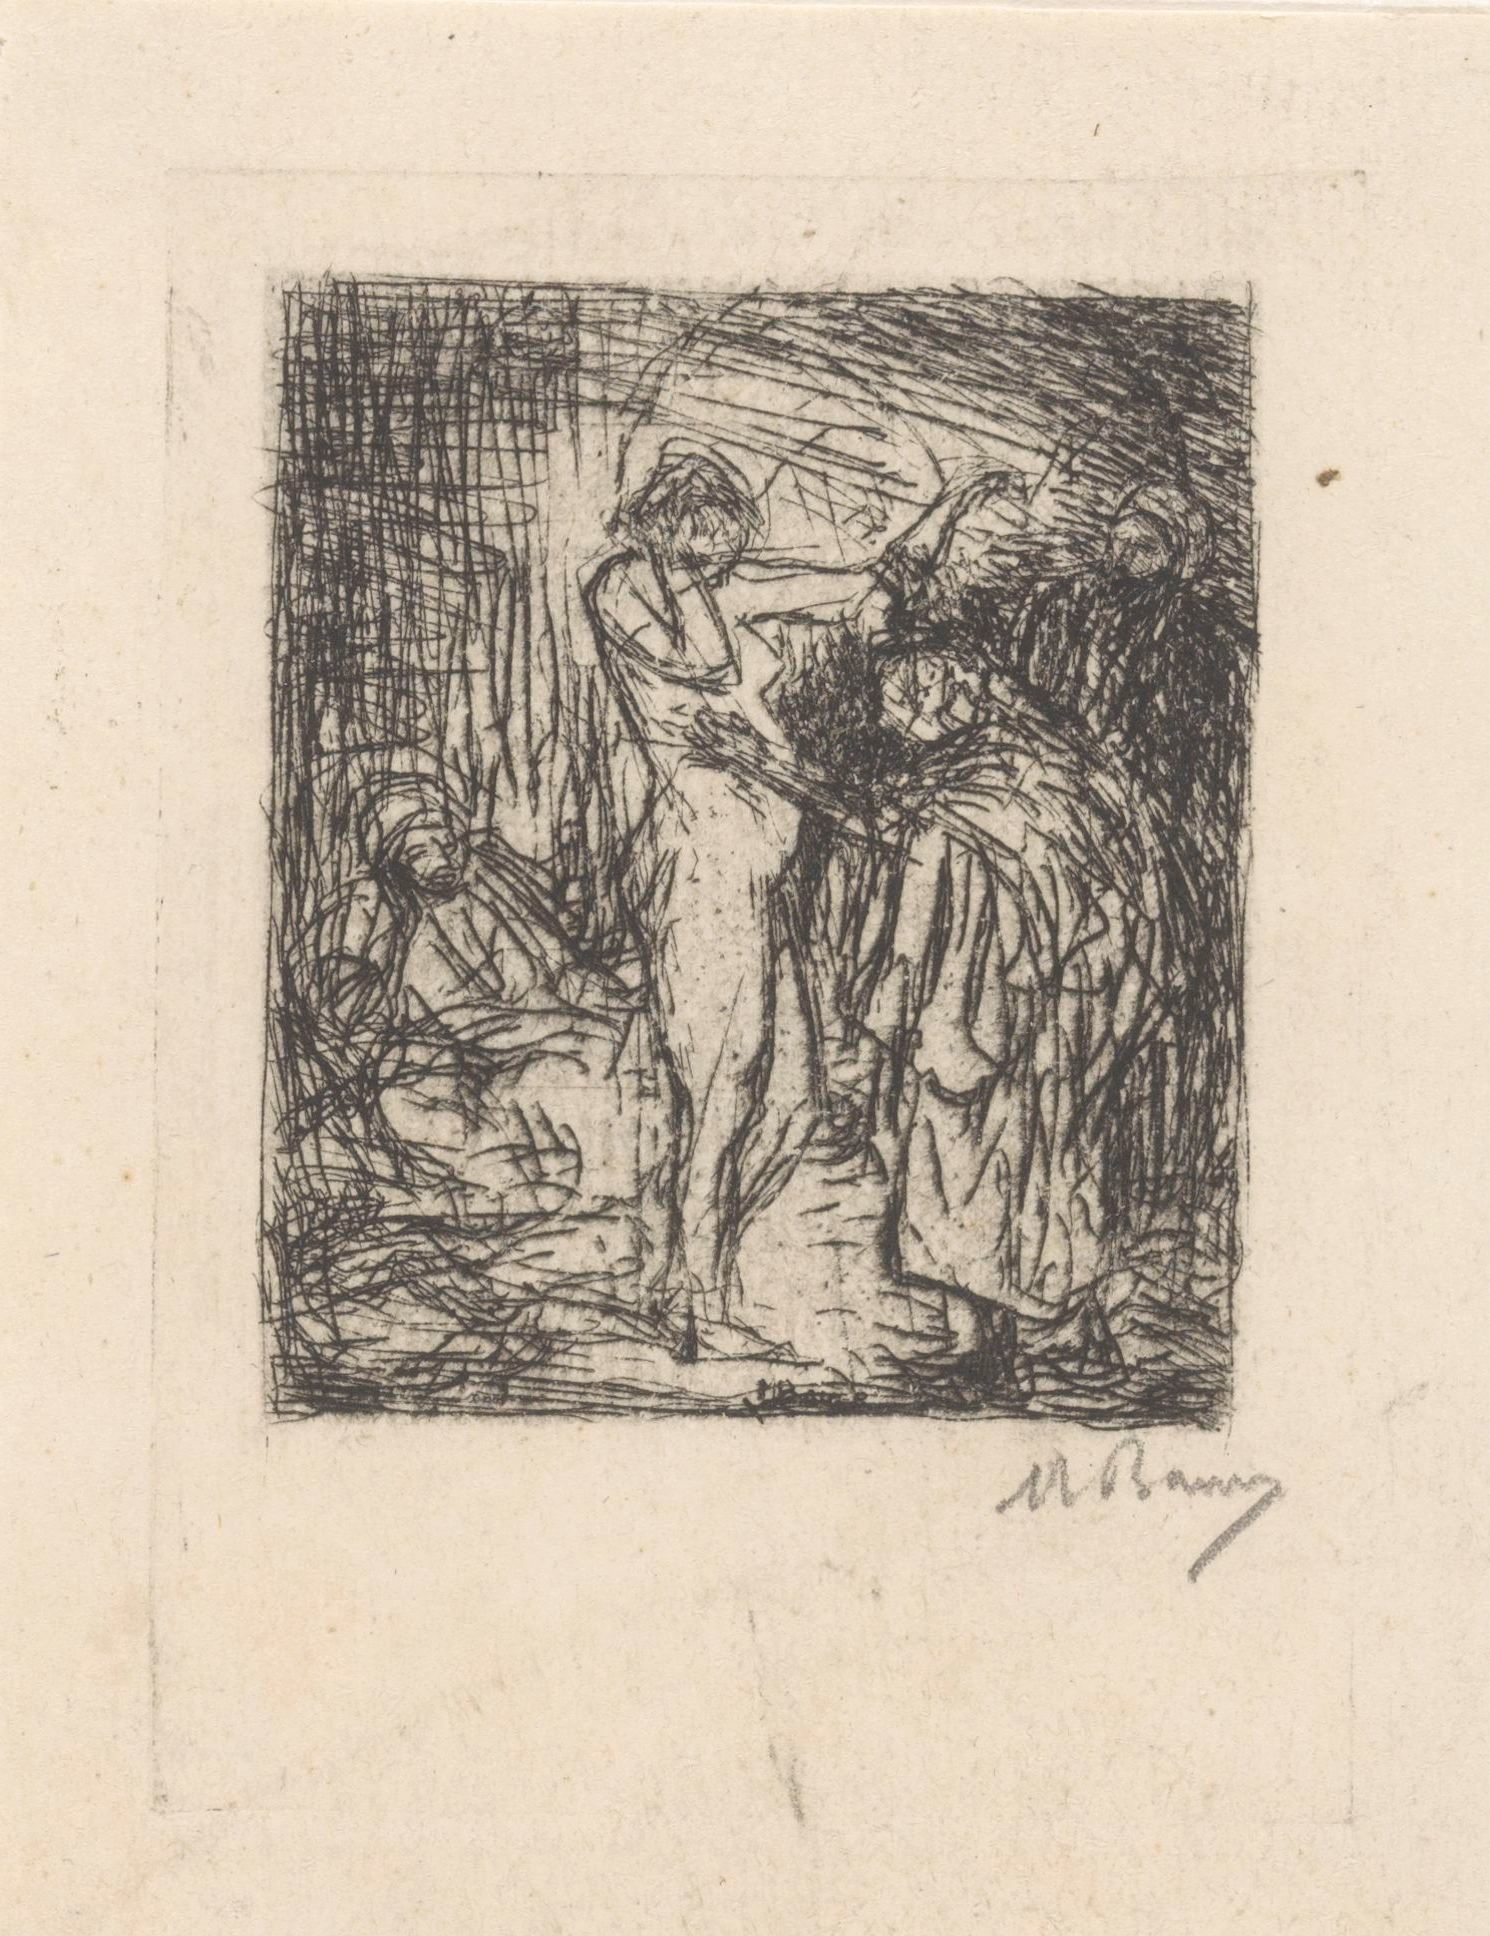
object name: print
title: Tot slaaf gemaakte vrouw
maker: marius bauer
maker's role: draughtsman, print maker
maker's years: 1867-1932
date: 1889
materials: paper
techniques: etching, intaglio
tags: slavery; serfs and enslaved persons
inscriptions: collector's mark: Lugt 2228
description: Een staande, naakte vrouw, te midden van drie figuren in oosterse kleding.